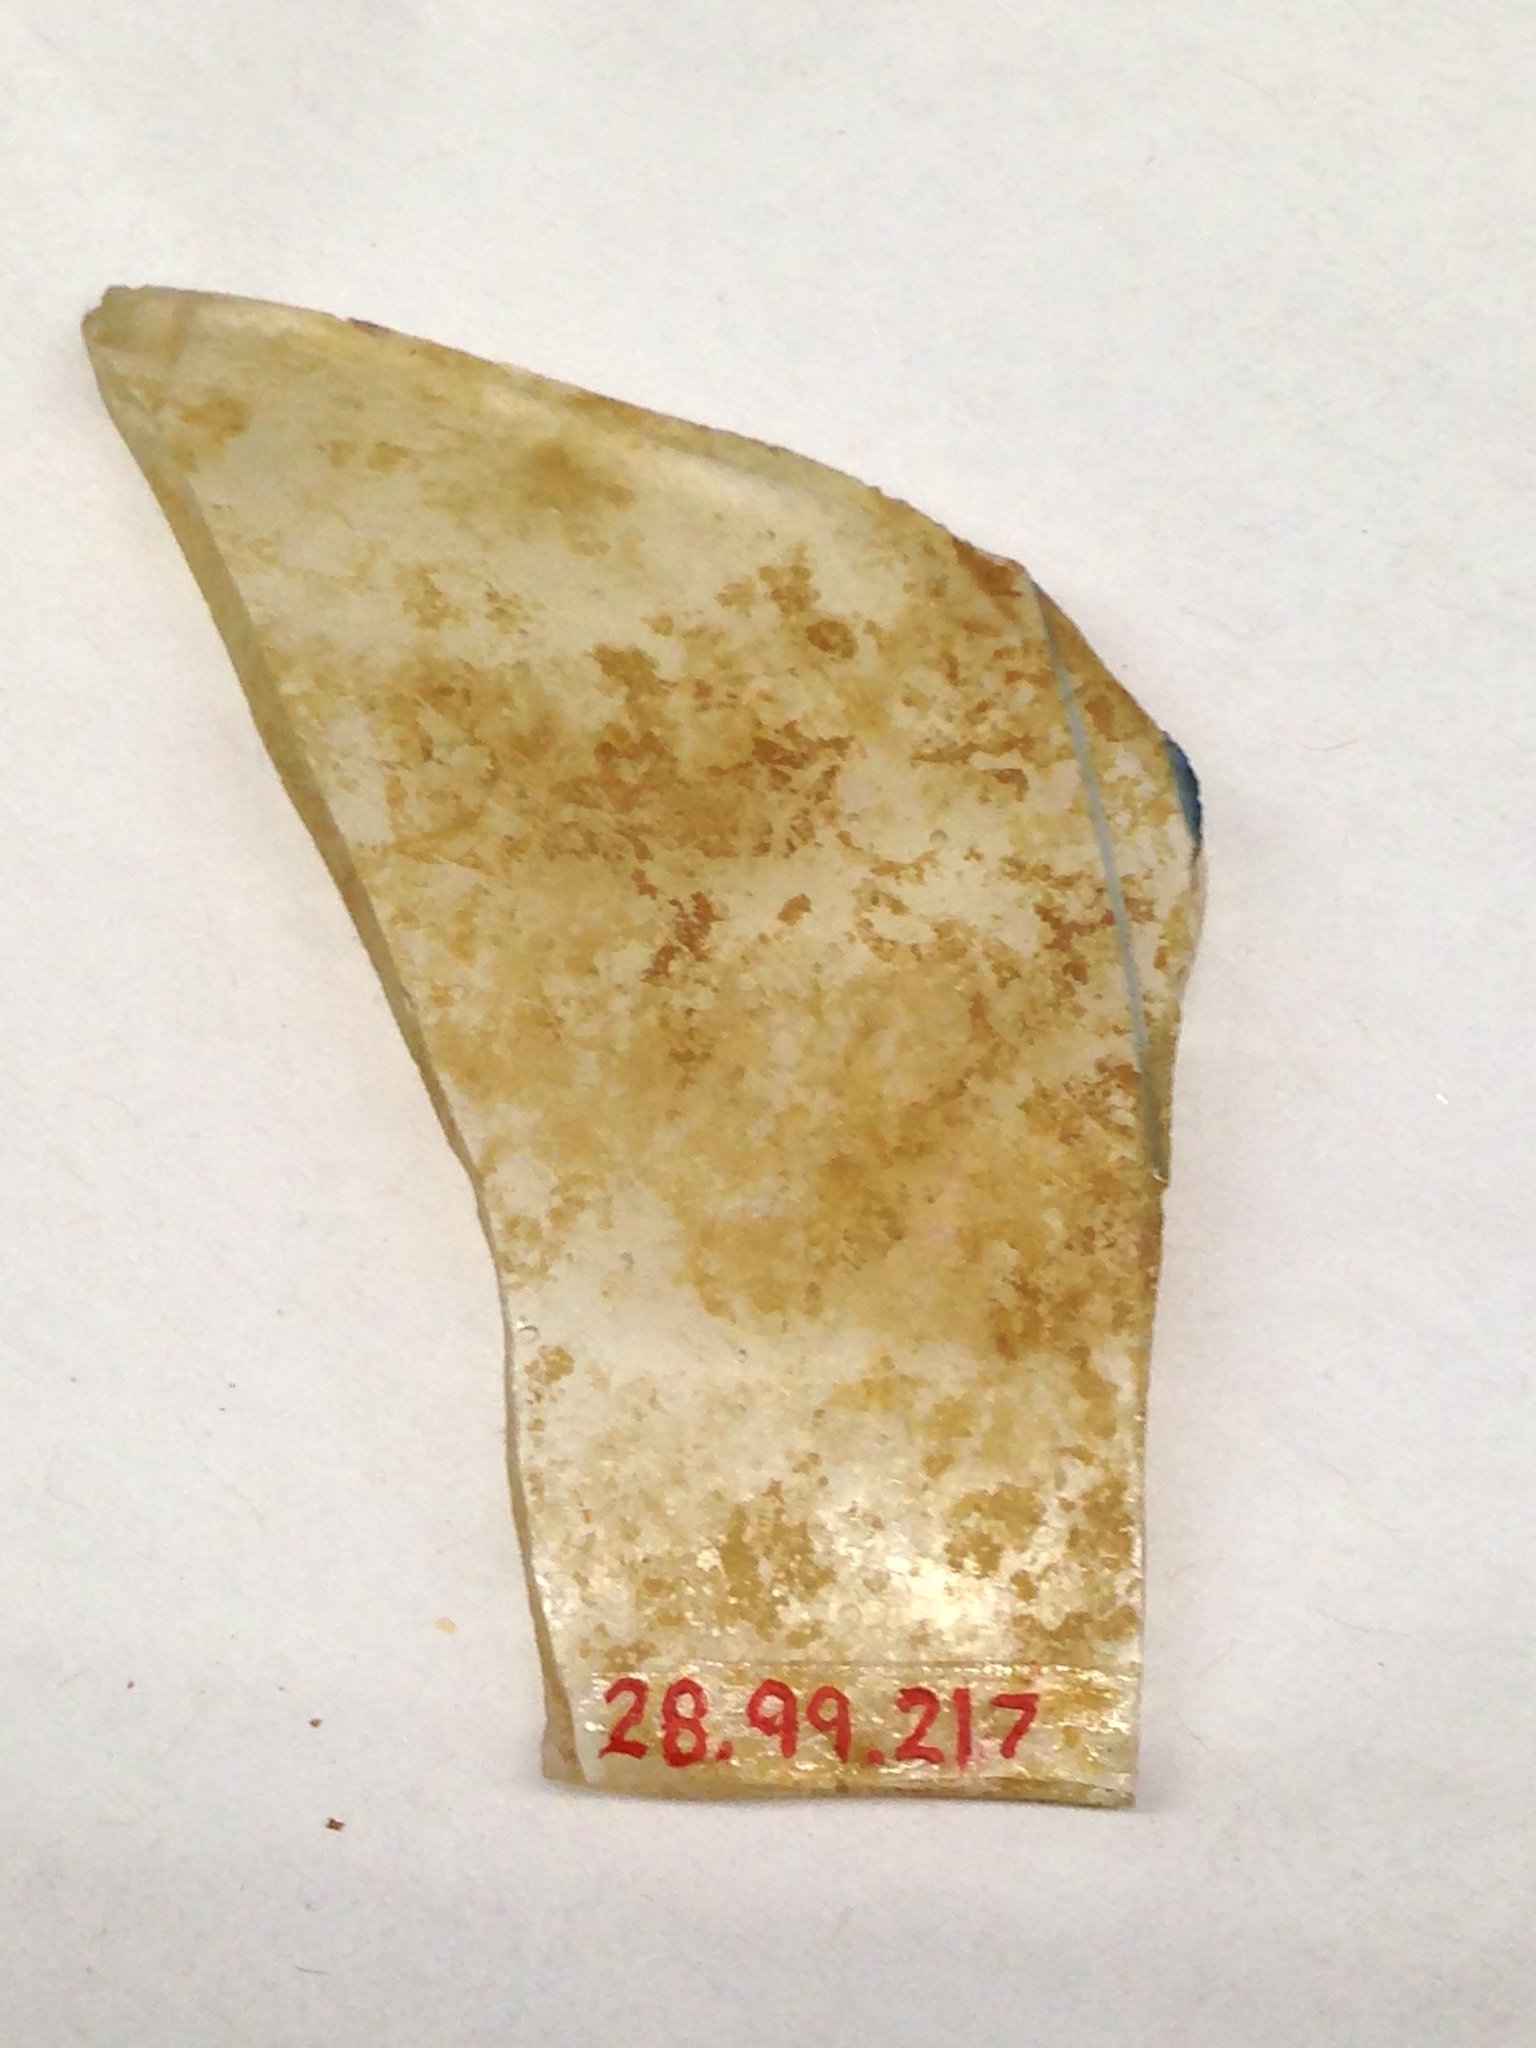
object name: fragment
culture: european or middle eastern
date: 1150-1250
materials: ceramic, glass